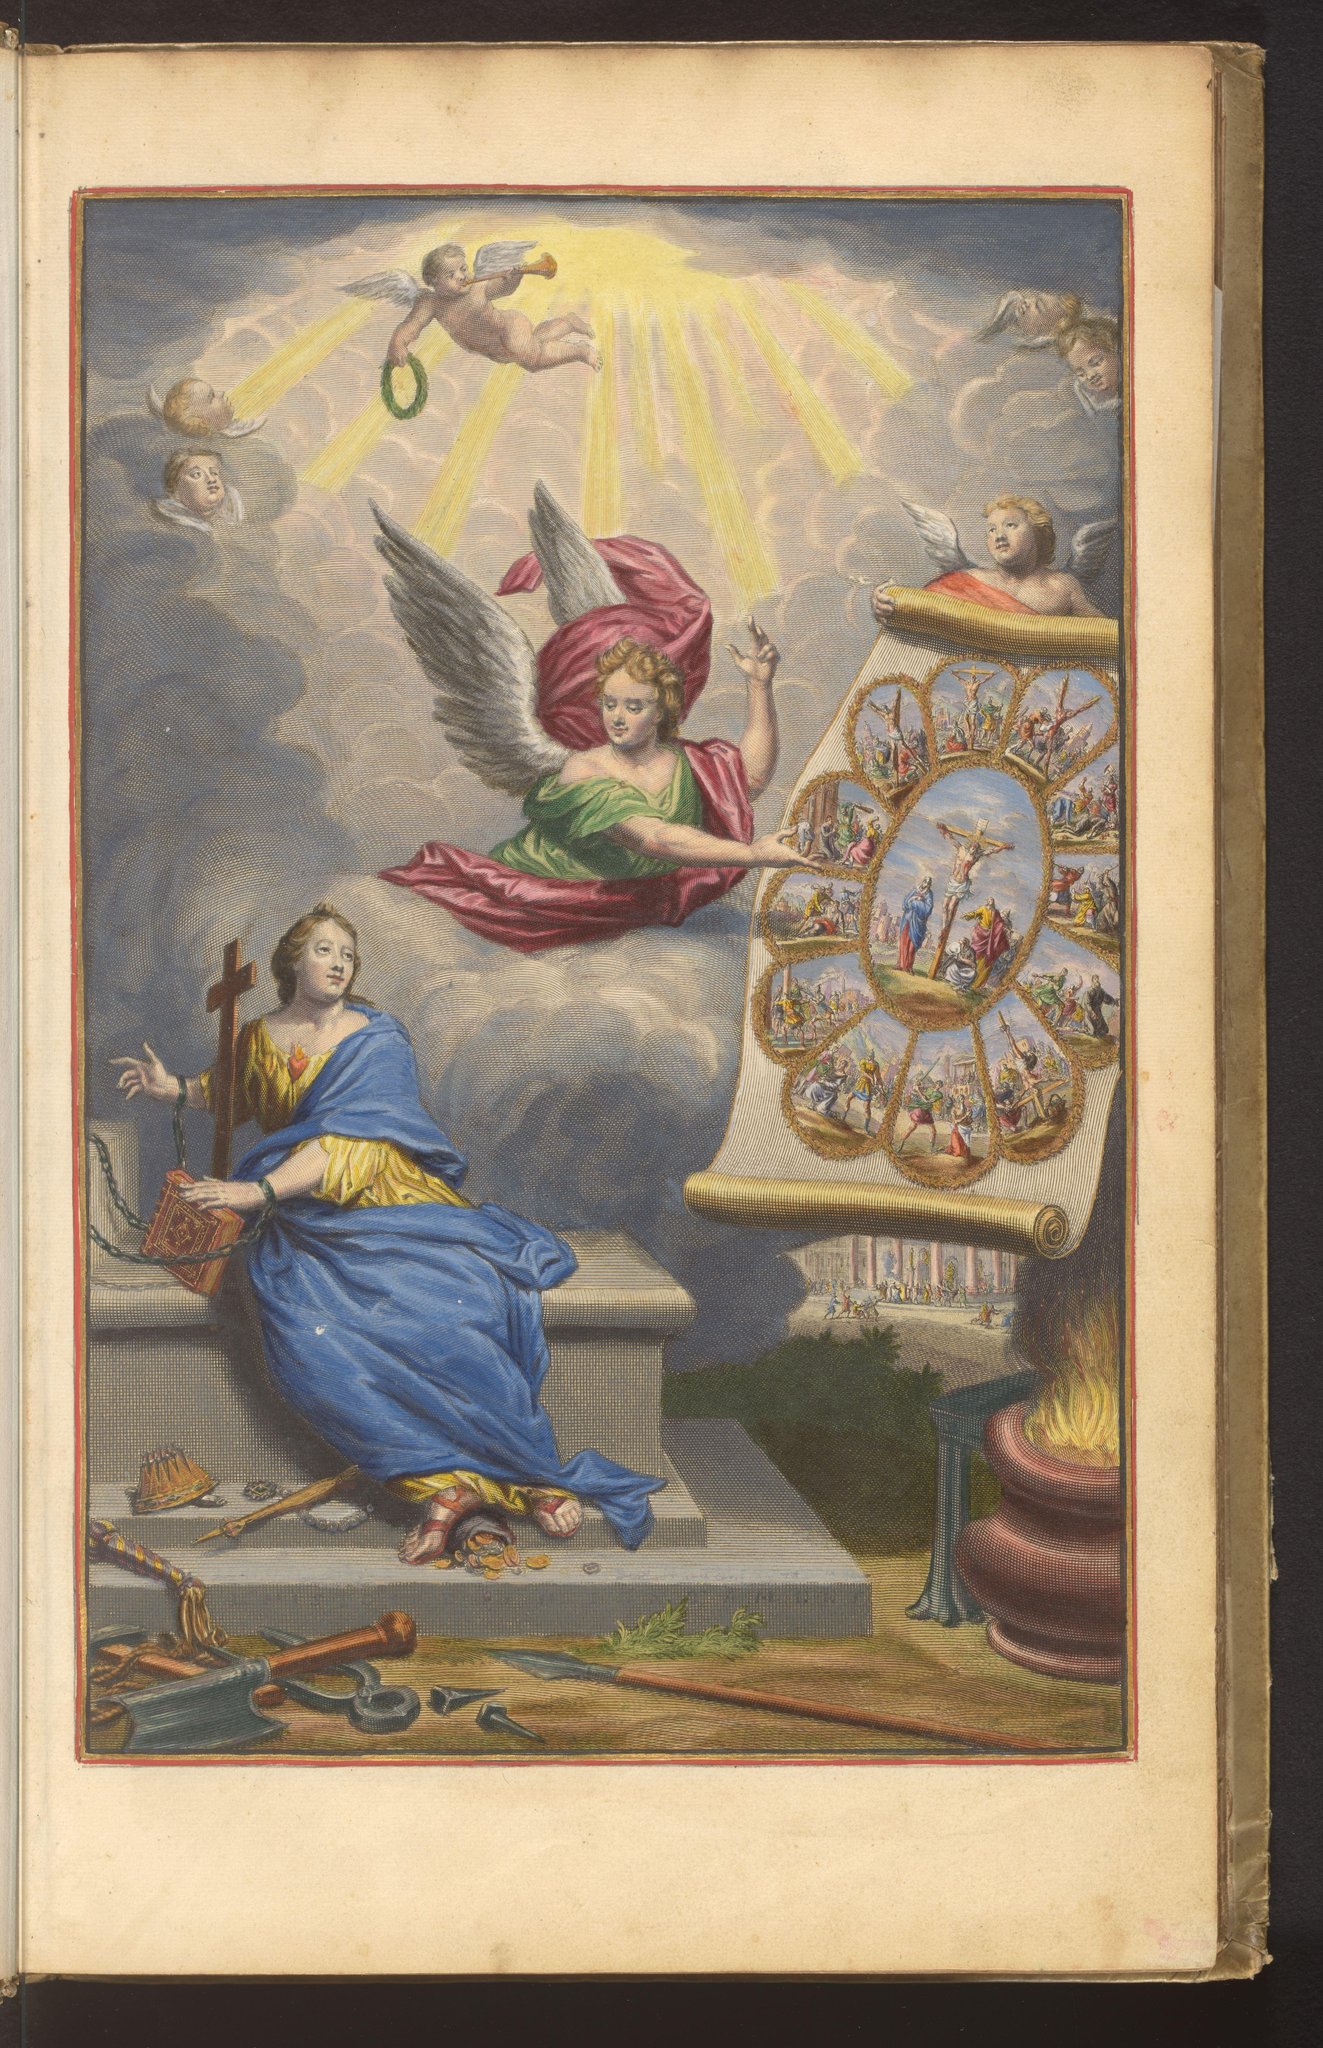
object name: titelprent, frontispice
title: Titelprent met engel die aan geketende Geloof het martelaarschap van Christus en de twaalf Apostelen toont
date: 1700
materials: paint, paper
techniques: engraving, etching, hand coloring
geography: amsterdam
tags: martyrdom and death of andrew, martyrdom and death of james, martyrdom and death of bartholomew, martyrdom and death of john, martyrdom and death of stephen, faith, 'fides'; 'fede', 'fede catholica', 'fede christiana', 'fede christiana catholica' (ripa) ~ one of the three theological virtues, martyrdom and death of philip, martyrdom and death of thomas, martyrdom and death of judas thaddaeus: he is beaten to death and beheaded, martyrdom and death of matthias, martyrdom and death of matthew, martyrdom and death of peter, martyrdom and death of paul, angels, the crucifixion of christ: christ's death on the cross; golgotha (matthew 27:45-58; mark 15:33-45; luke 23:44-52; john 19:25-38)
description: De personificatie van het Geloof zit geketend op de grond. In haar handen een kruis en een bijbel. Naast haar op de grond liggen de passiewerktuigen en symbolen van wereldse zaken. Een engel verschijnt in de lucht en toont haar een voorstelling van de kruisiging van Christus, omringd door verschillende kleinere voorstellingen van het martelaarschap van de twaalf apostelen. Titelprent voor het tweede deel van de prentbijbel met het Nieuwe Testament, uitgegeven door Pieter Mortier, Amsterdam 1700.